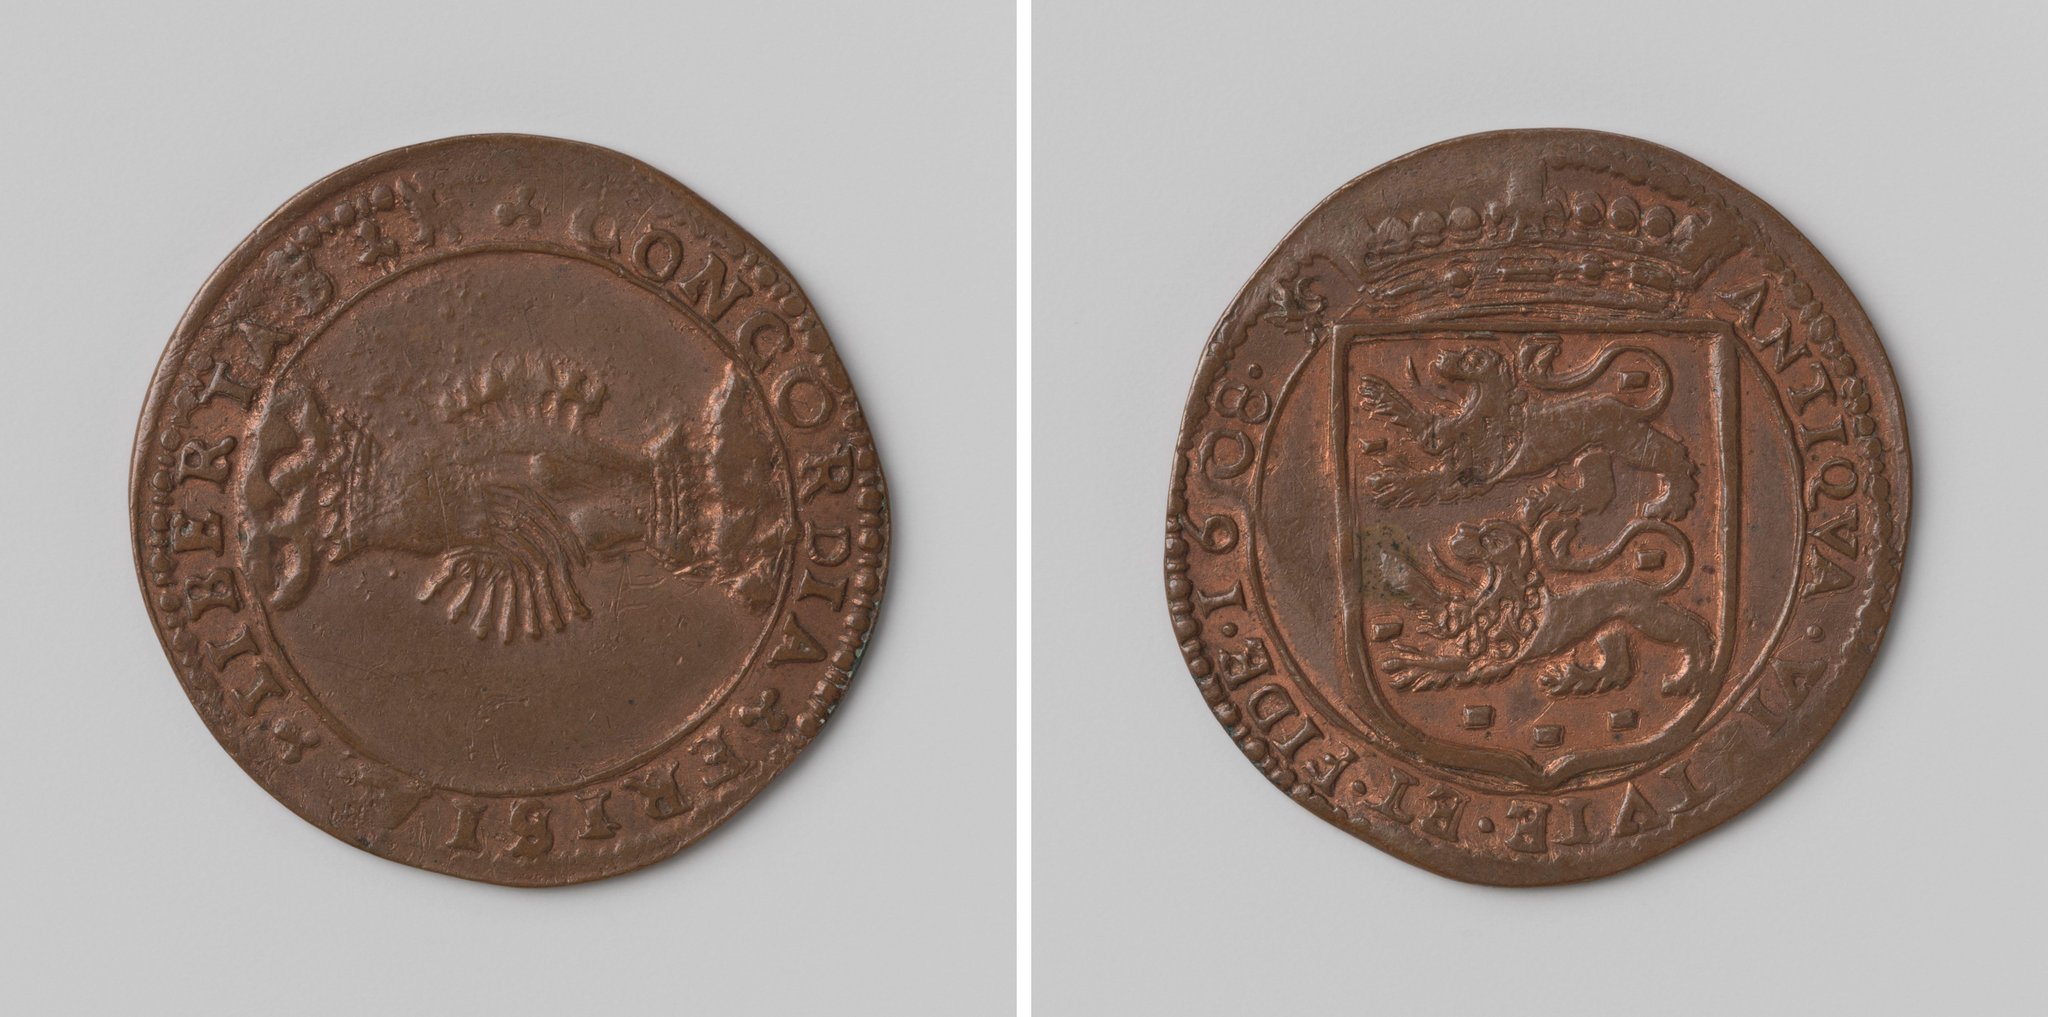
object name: jeton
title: Twaalfjarig Bestand tussen de Republiek en Spanje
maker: Anonymous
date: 1608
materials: copper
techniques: striking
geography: hoorn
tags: staten van west-friesland, west-friesland, twaalfjarig bestand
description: Koperen penning. Voorzijde: twee ineen geslagen handen houden samen bundel van zeven pijlen vast binnen omschrift. Keerzijde: gekroond wapenschild binnen omschrift